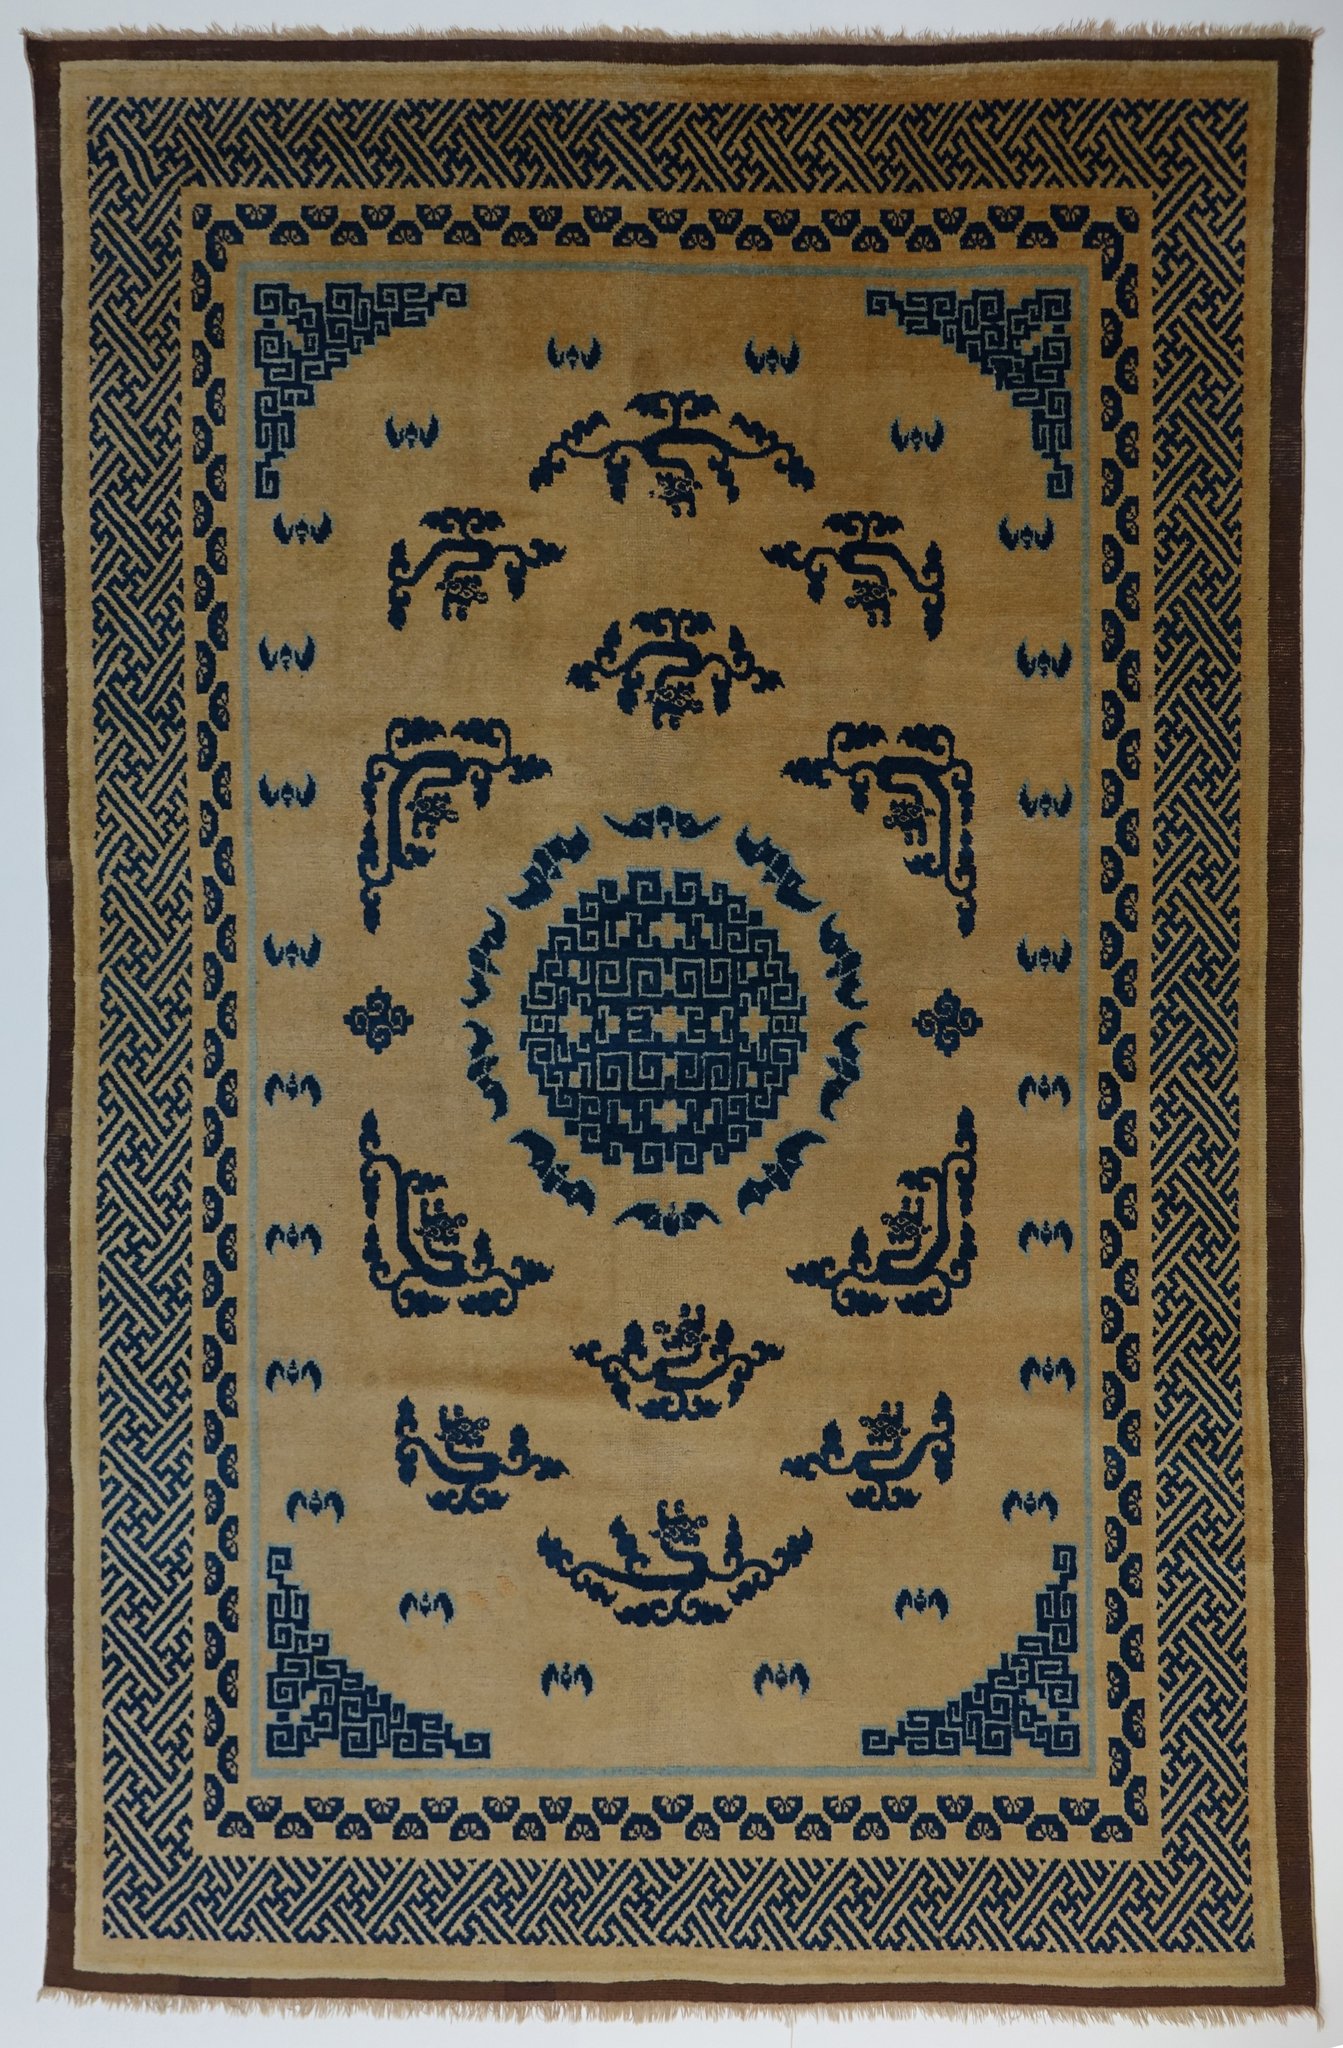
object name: carpet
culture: chinese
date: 1767-1900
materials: cotton, wool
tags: bats,dragons